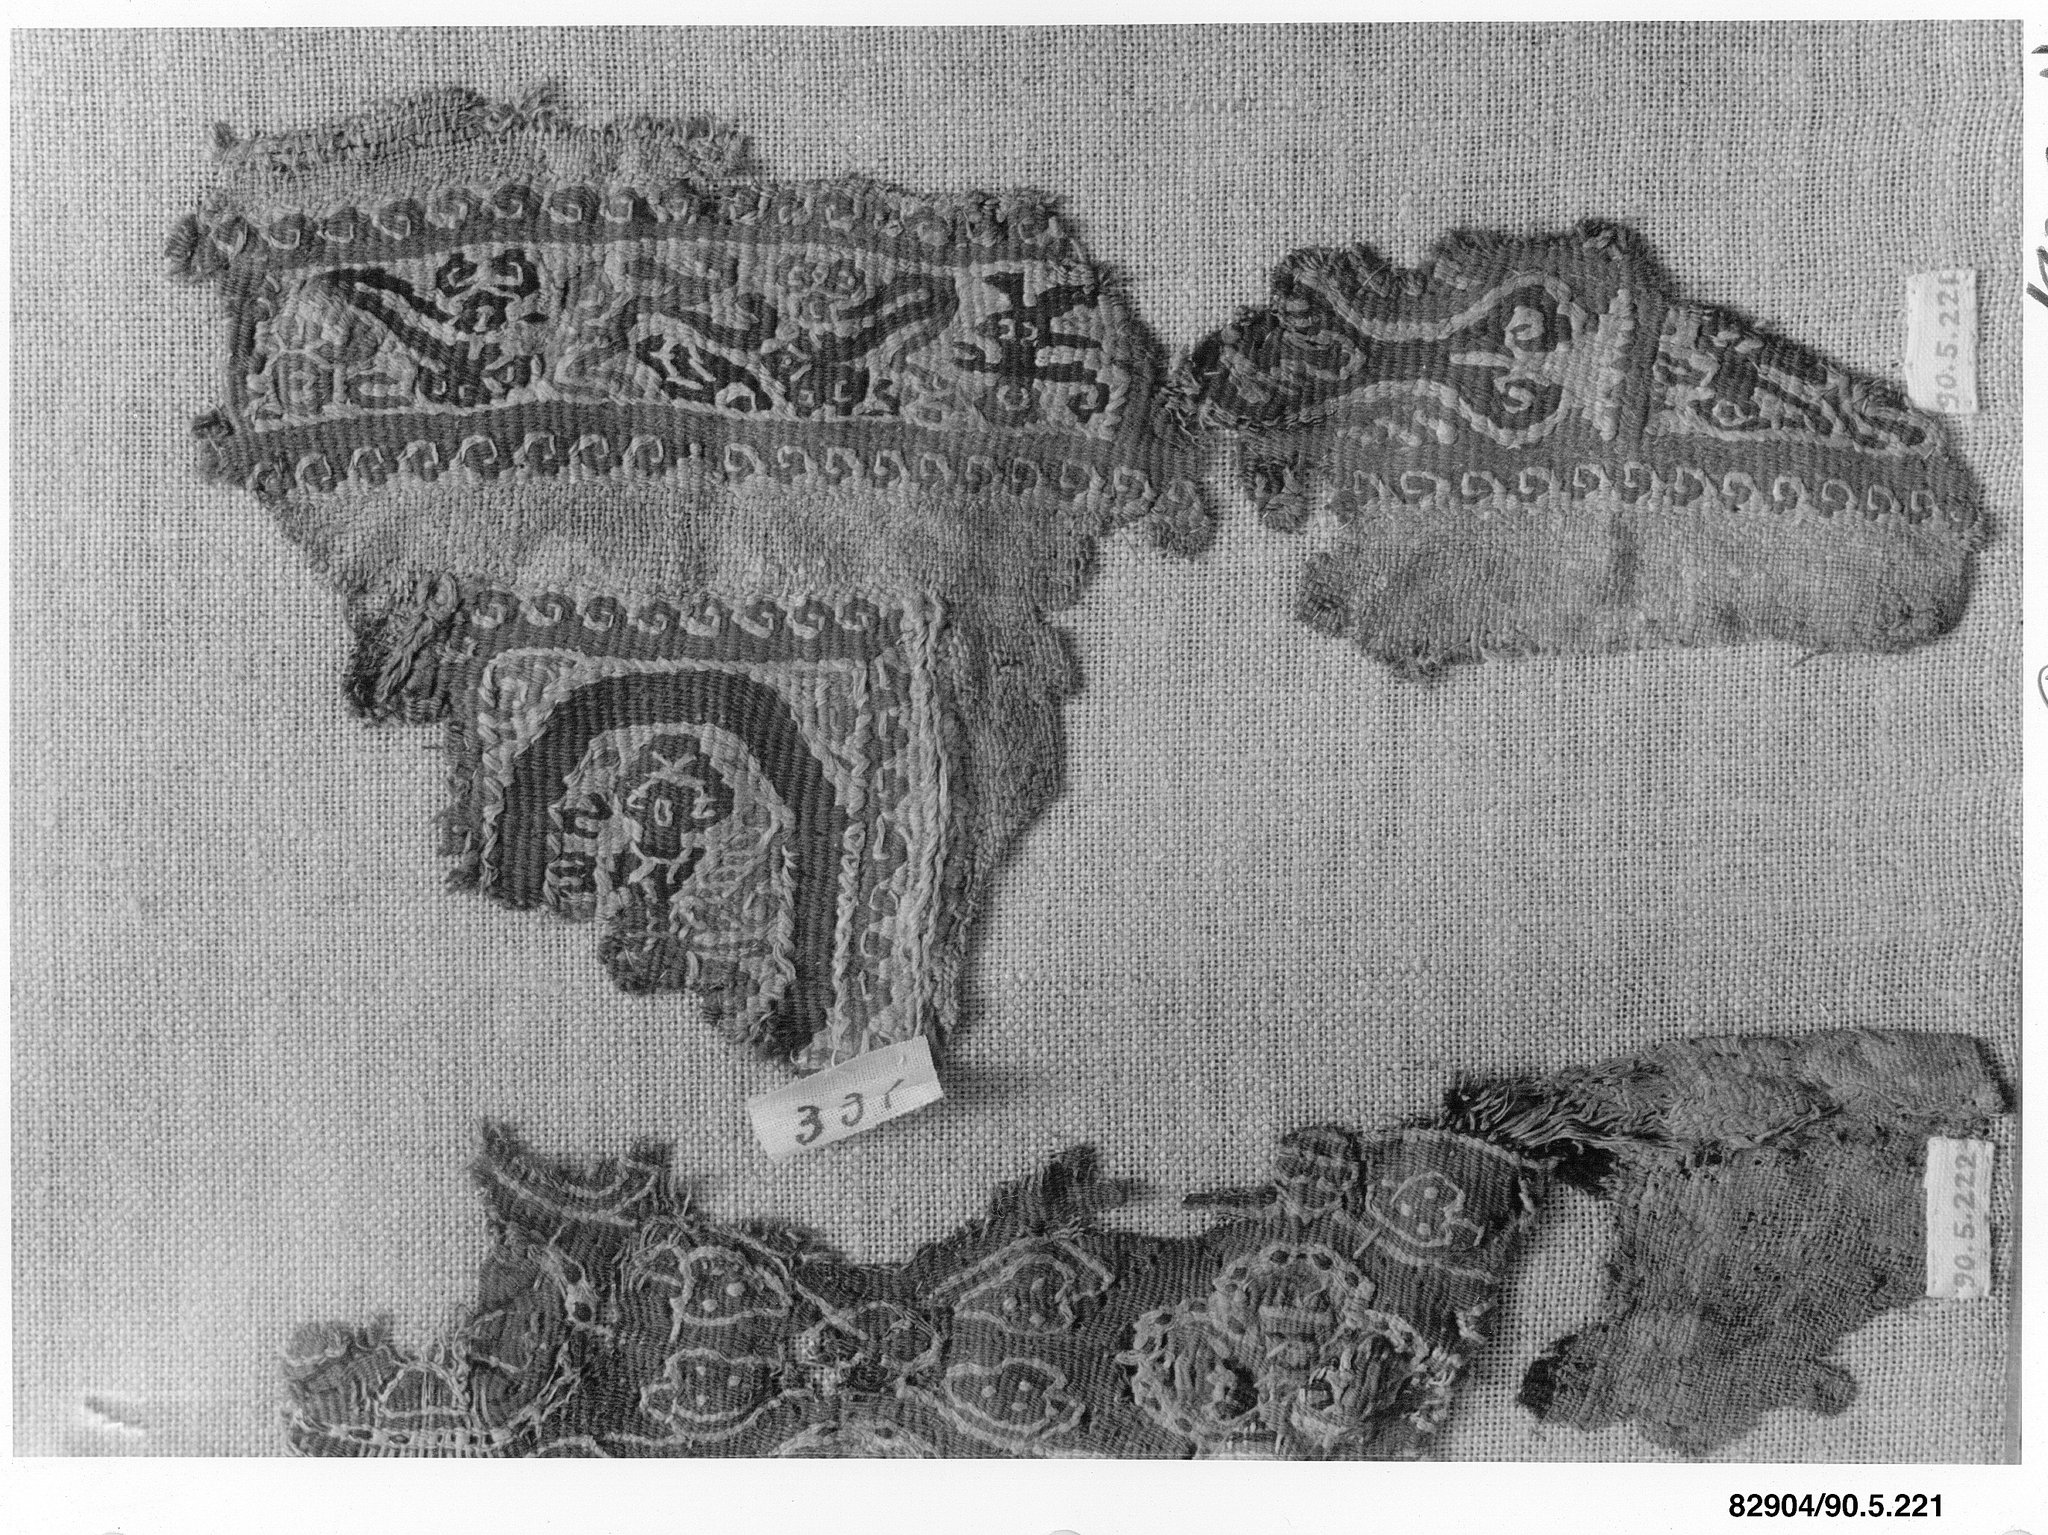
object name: textile fragment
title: Fragment of a Tunic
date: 401-600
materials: linen, wool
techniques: weave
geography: egypt